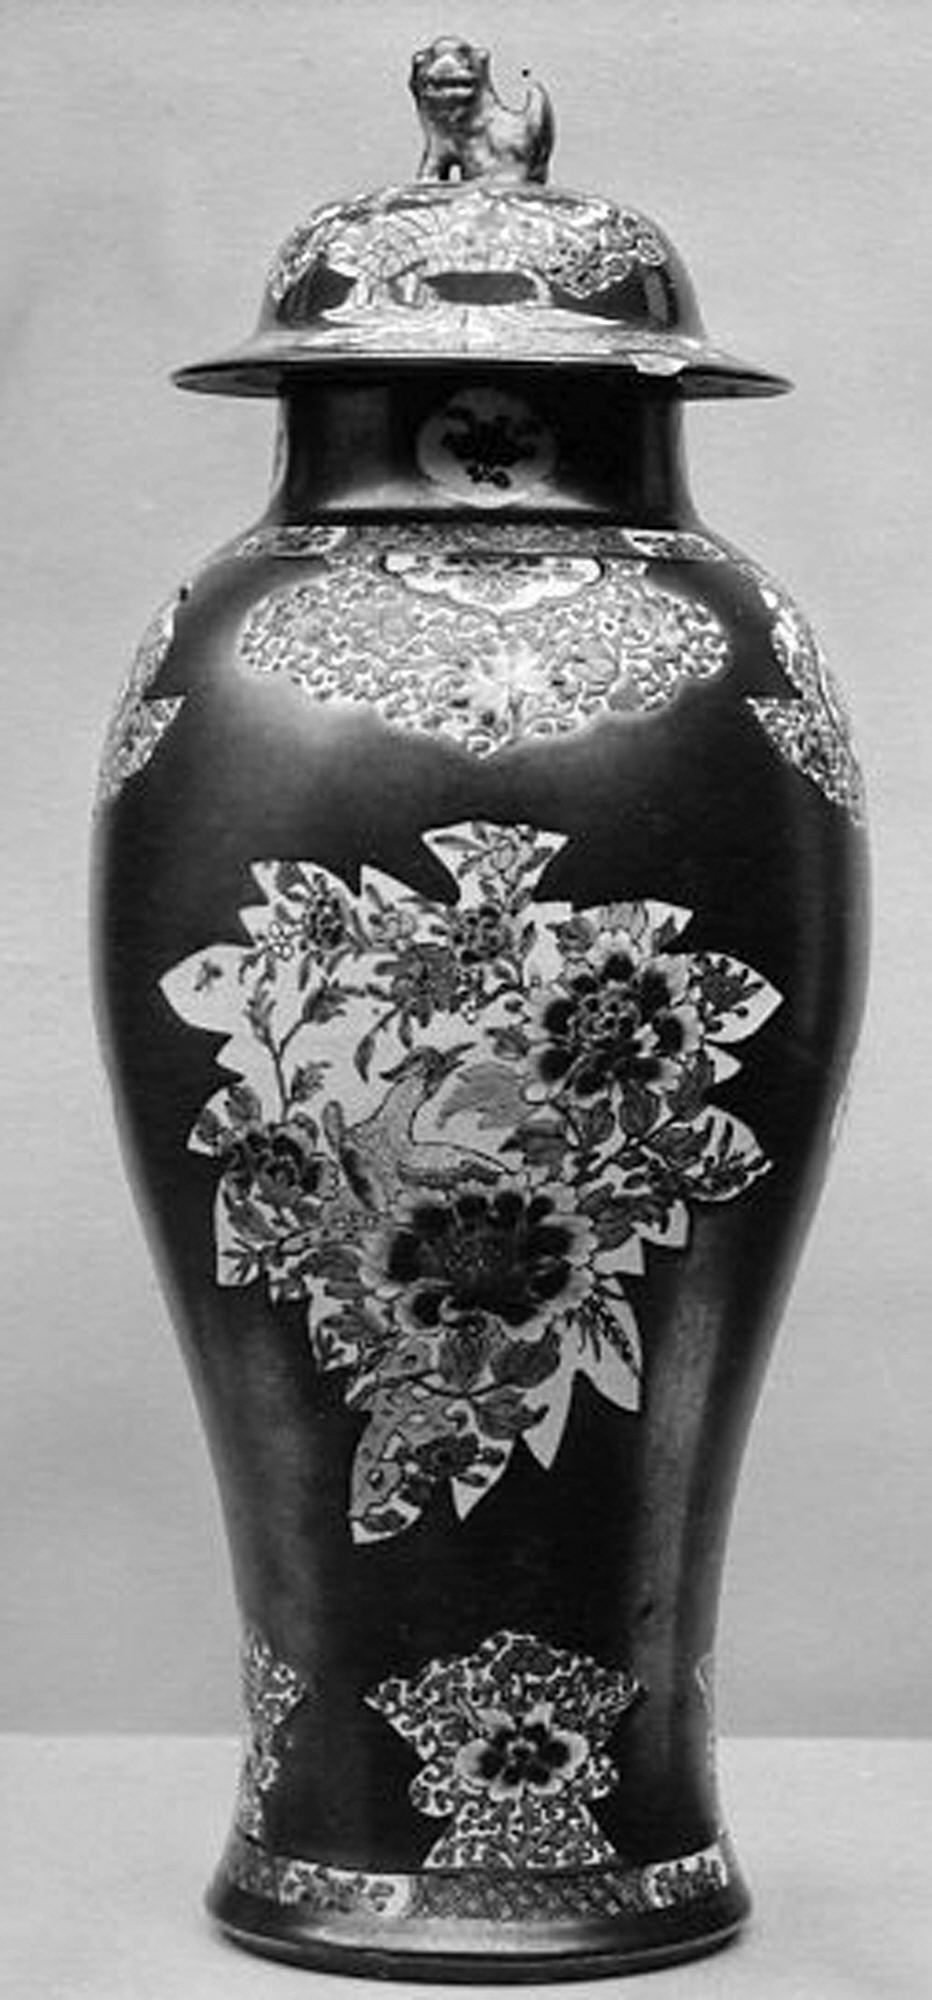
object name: covered jar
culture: chinese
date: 1736-1795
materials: porcelain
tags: flowers